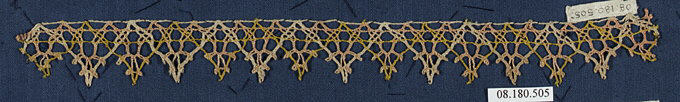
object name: fragment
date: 1501-1600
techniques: lace